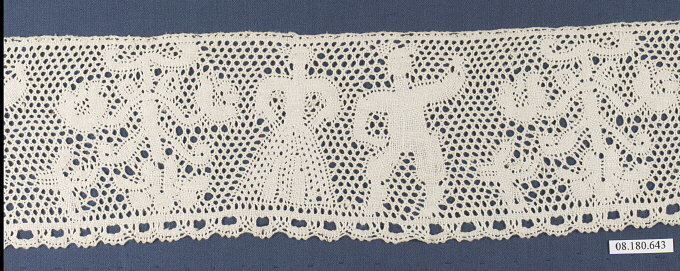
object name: piece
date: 1801-1900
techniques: lace